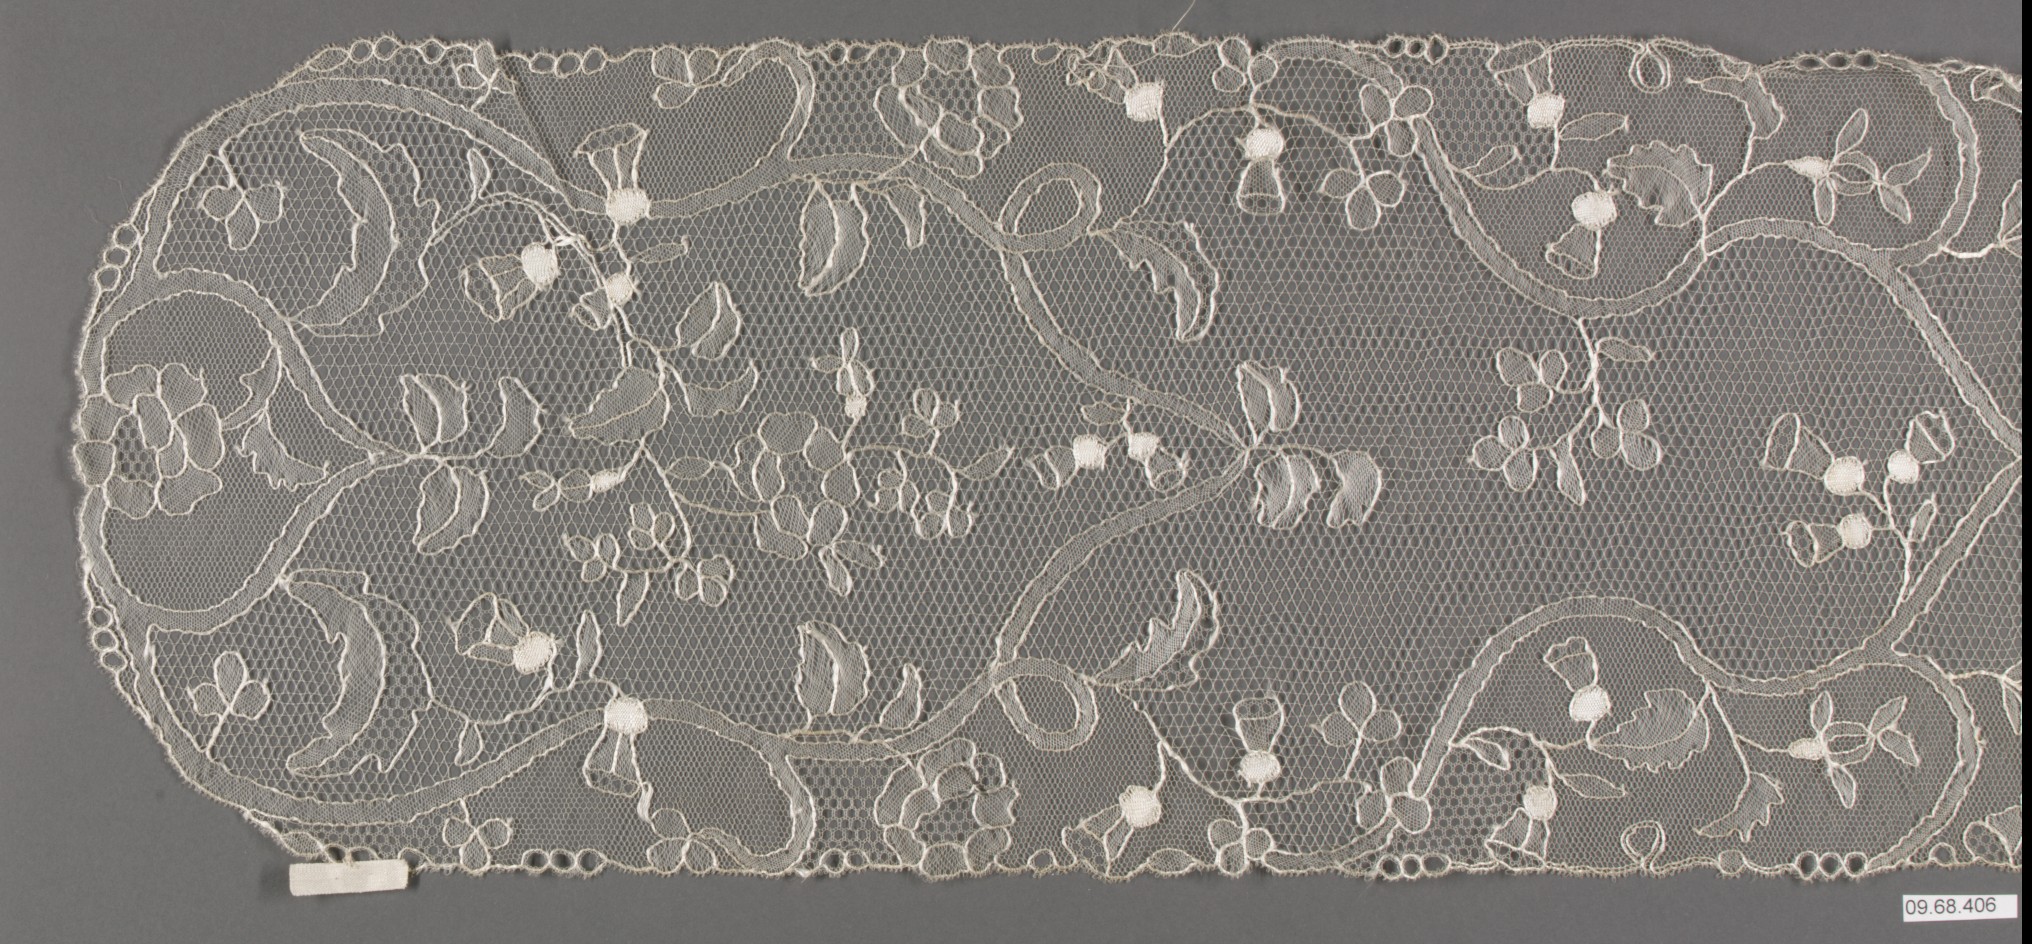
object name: scarf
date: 1801-1900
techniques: lace